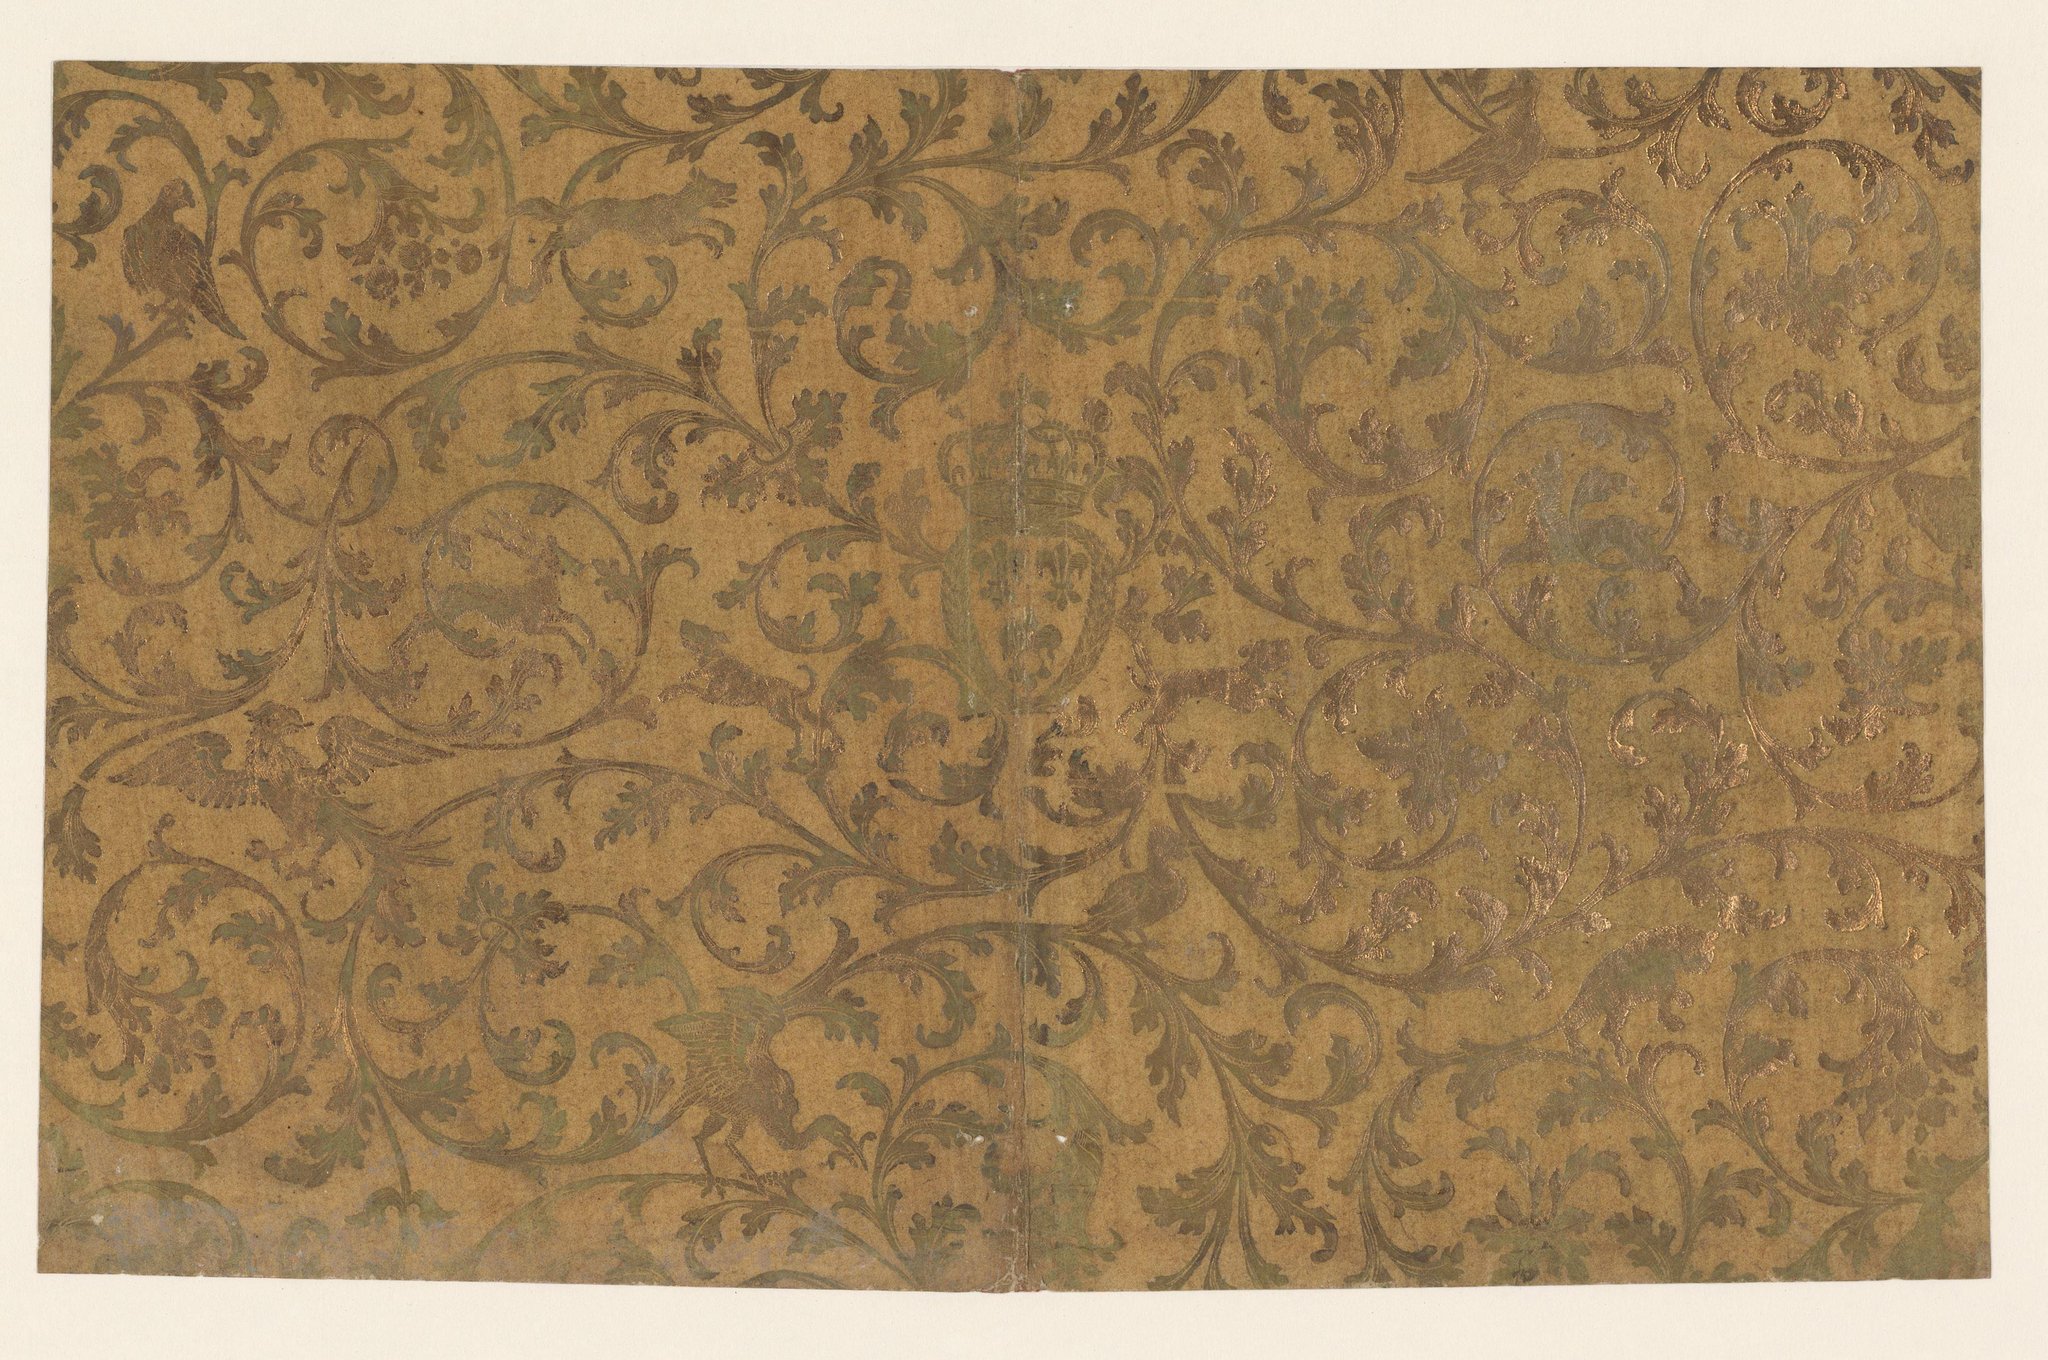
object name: wrapper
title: Blad met wapen met Franse lelies en patroon van dieren tussen ranken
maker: Anonymous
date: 1690-1790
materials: gold leaf, paper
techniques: relief print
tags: ornament derived from animal forms, hunting, chase, ornament derived from plant forms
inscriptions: annotation: ‘1708 [of] 1768’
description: Blad met in het midden, op de vouw, een gekroond wapenschild met drie Franse lelies in een patroon van dieren (jachthond met hert, verschillende vogels, katachtige) tussen ranken.